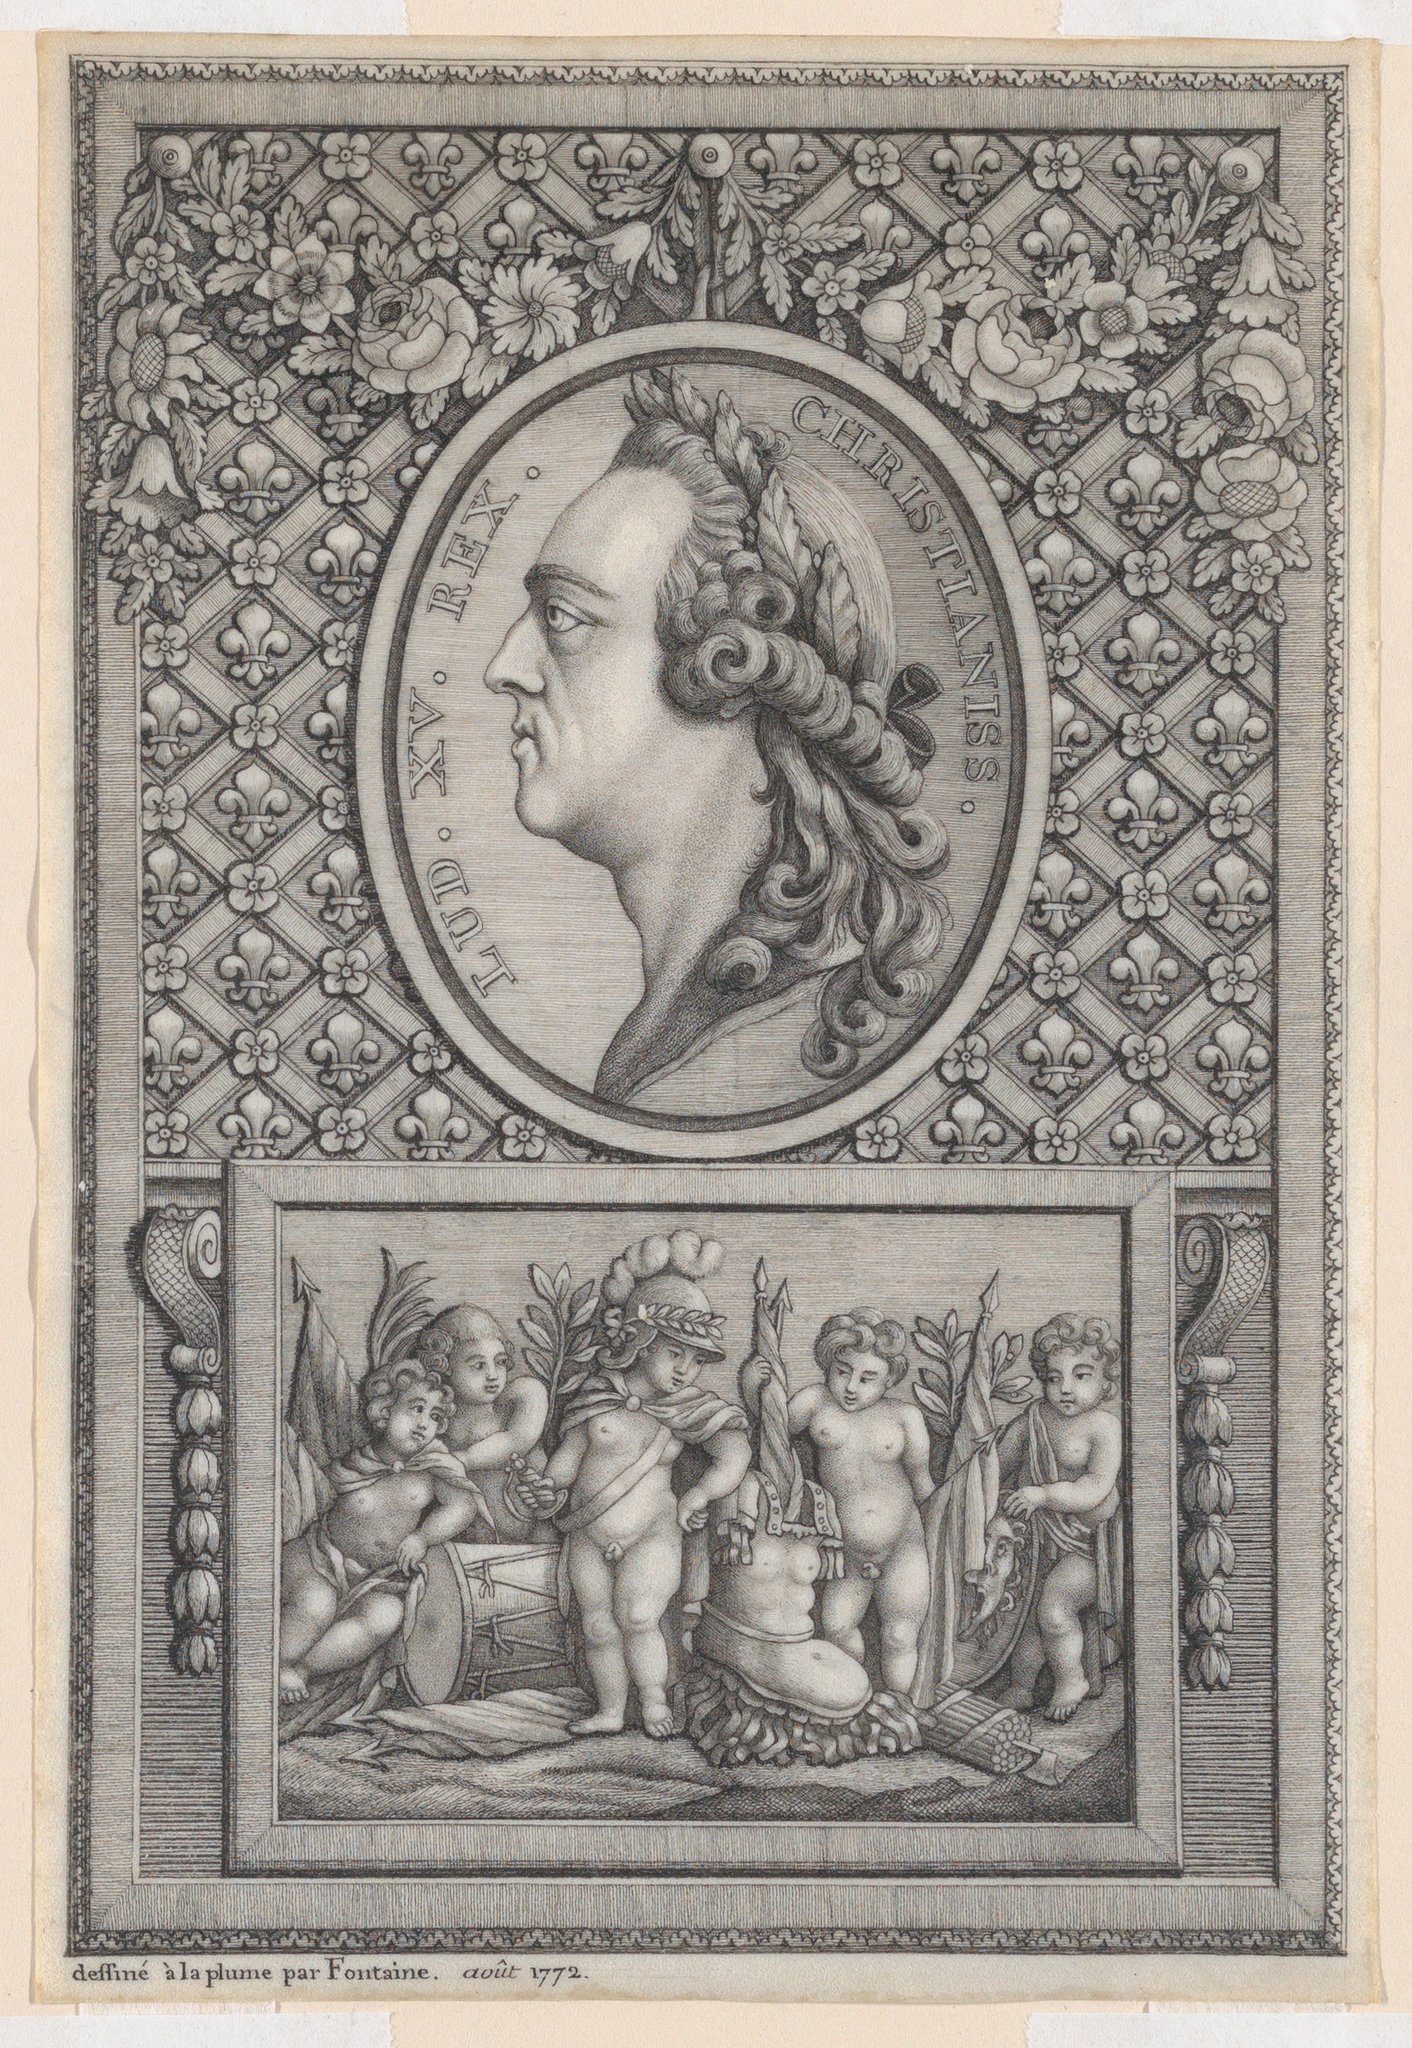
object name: drawing ornament architecture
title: Portrait Medallion of King Louis XV set in a Decorative Frame with a Relief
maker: fontaine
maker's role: artist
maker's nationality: french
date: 1772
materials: chalk, ink, parchment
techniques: pen, drawing